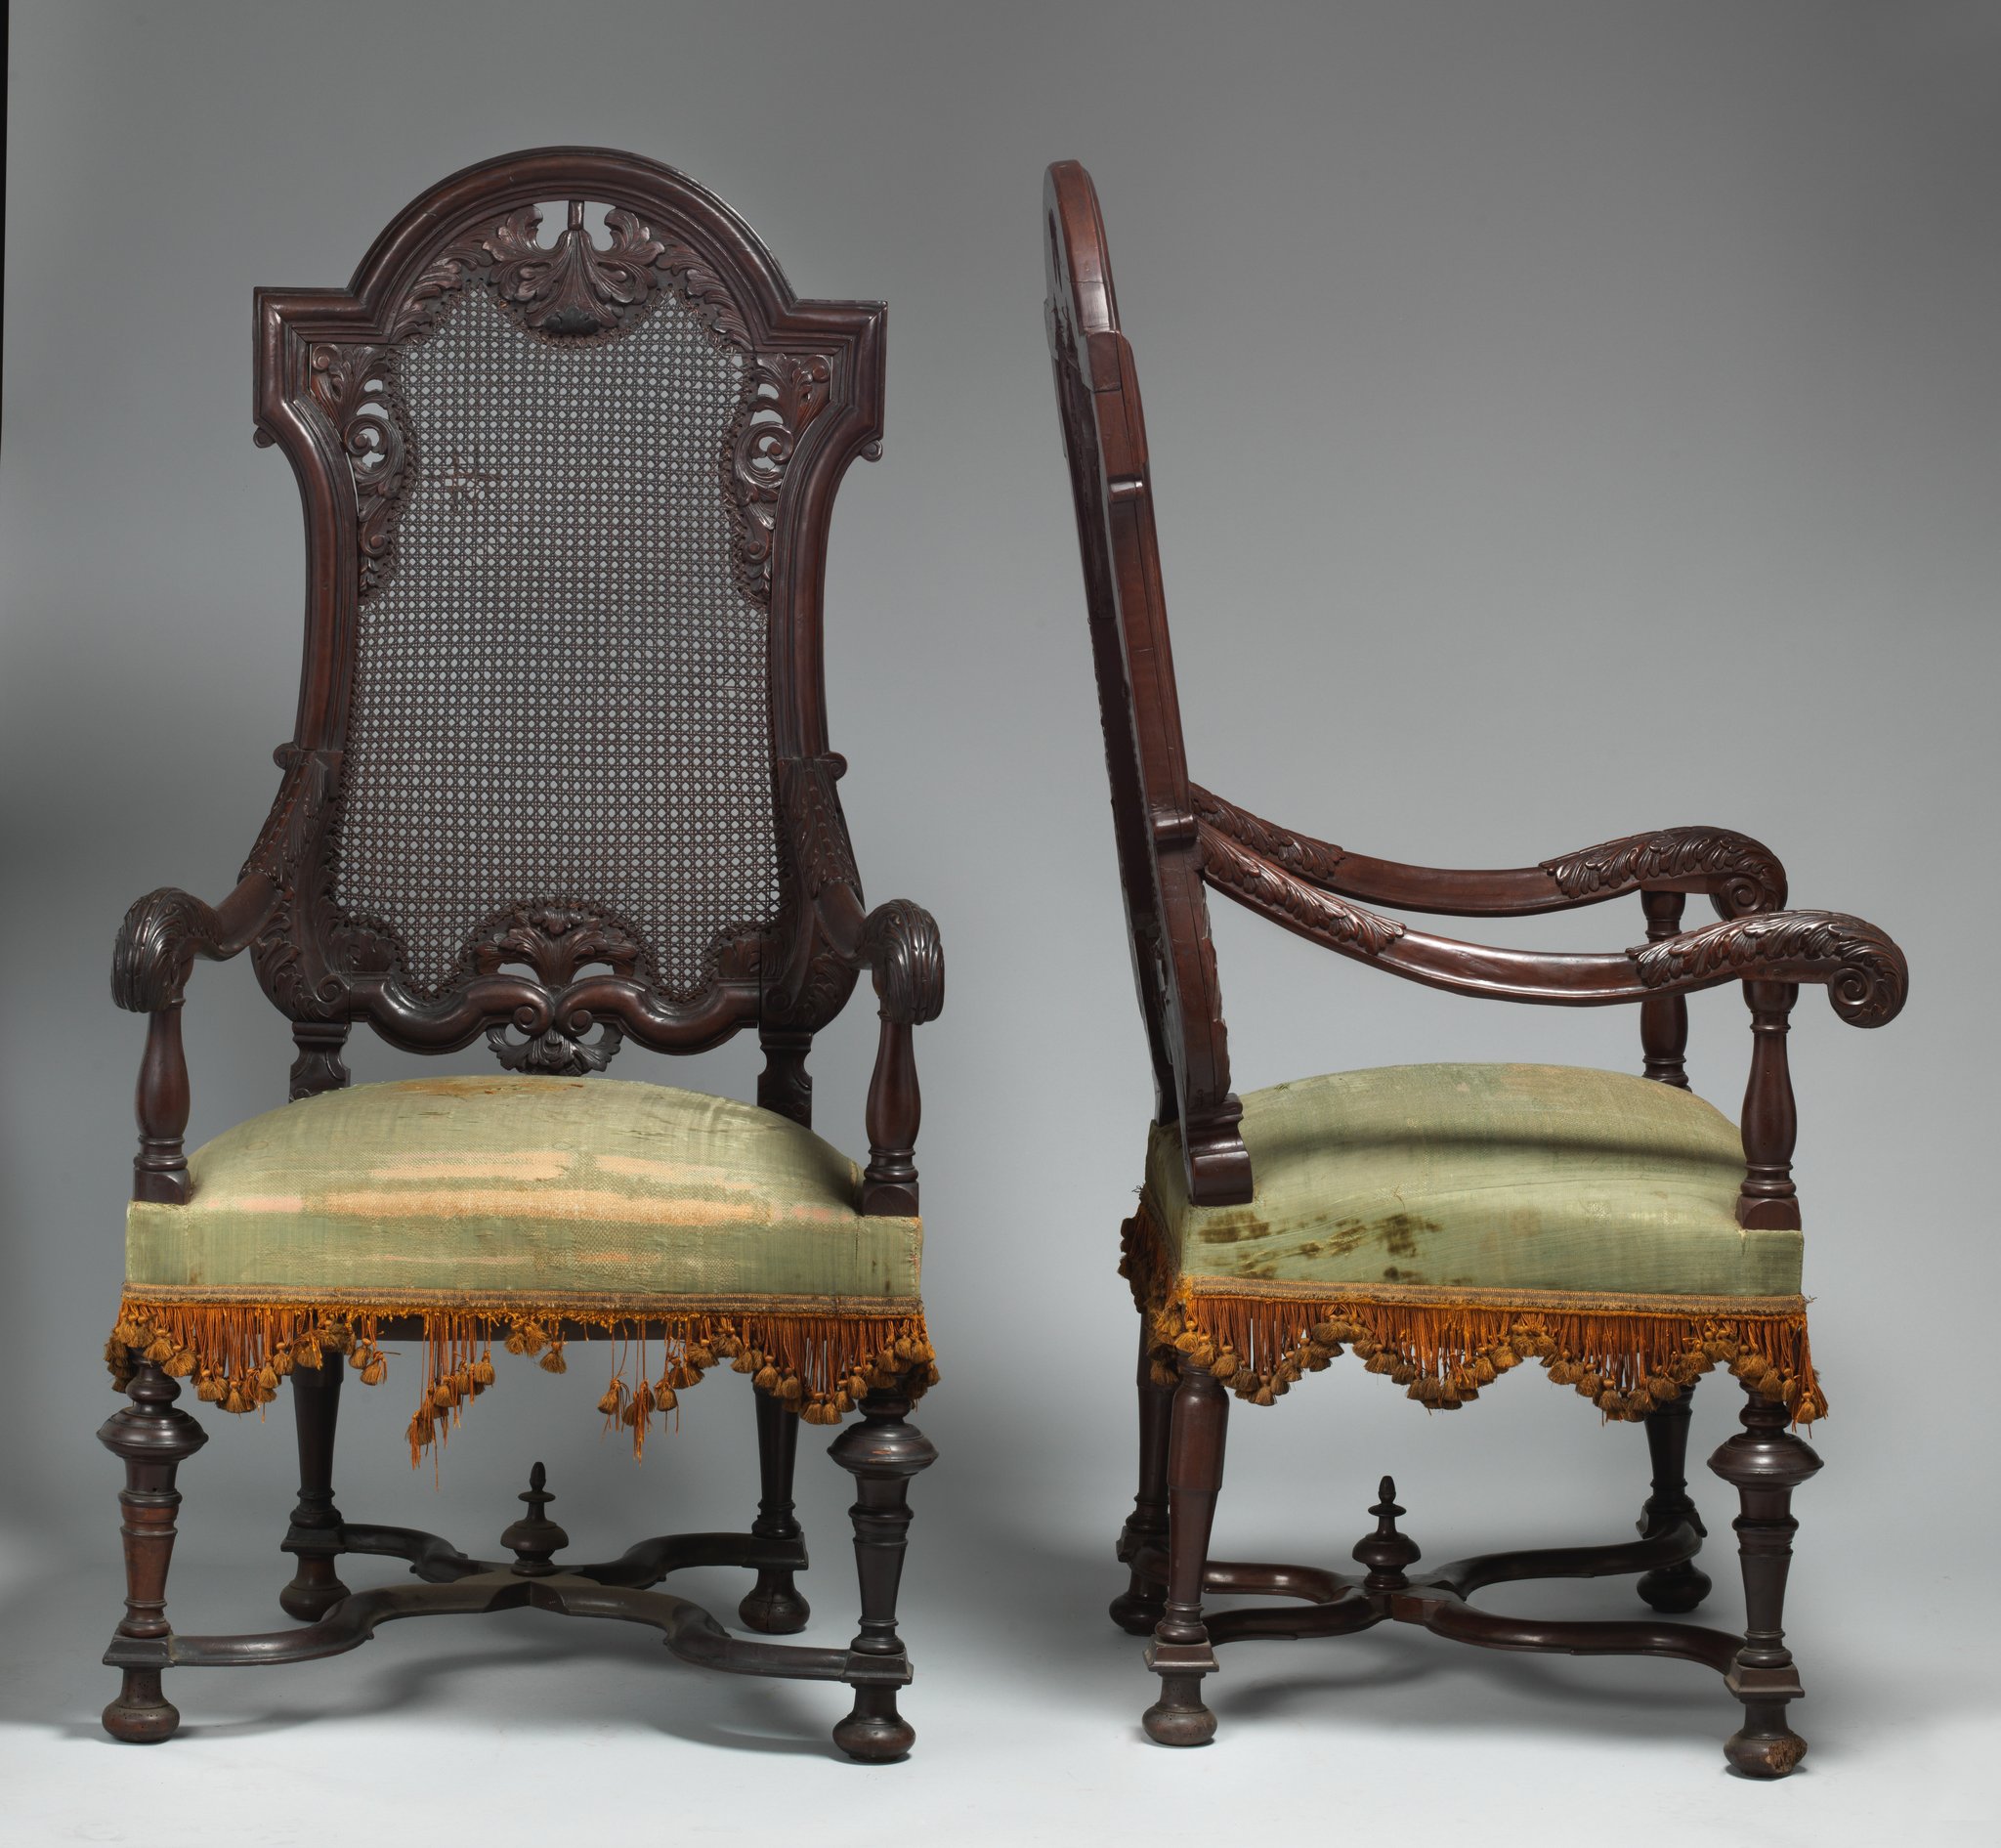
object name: armchair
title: Armchair (one of a pair)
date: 1689-1702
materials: wood